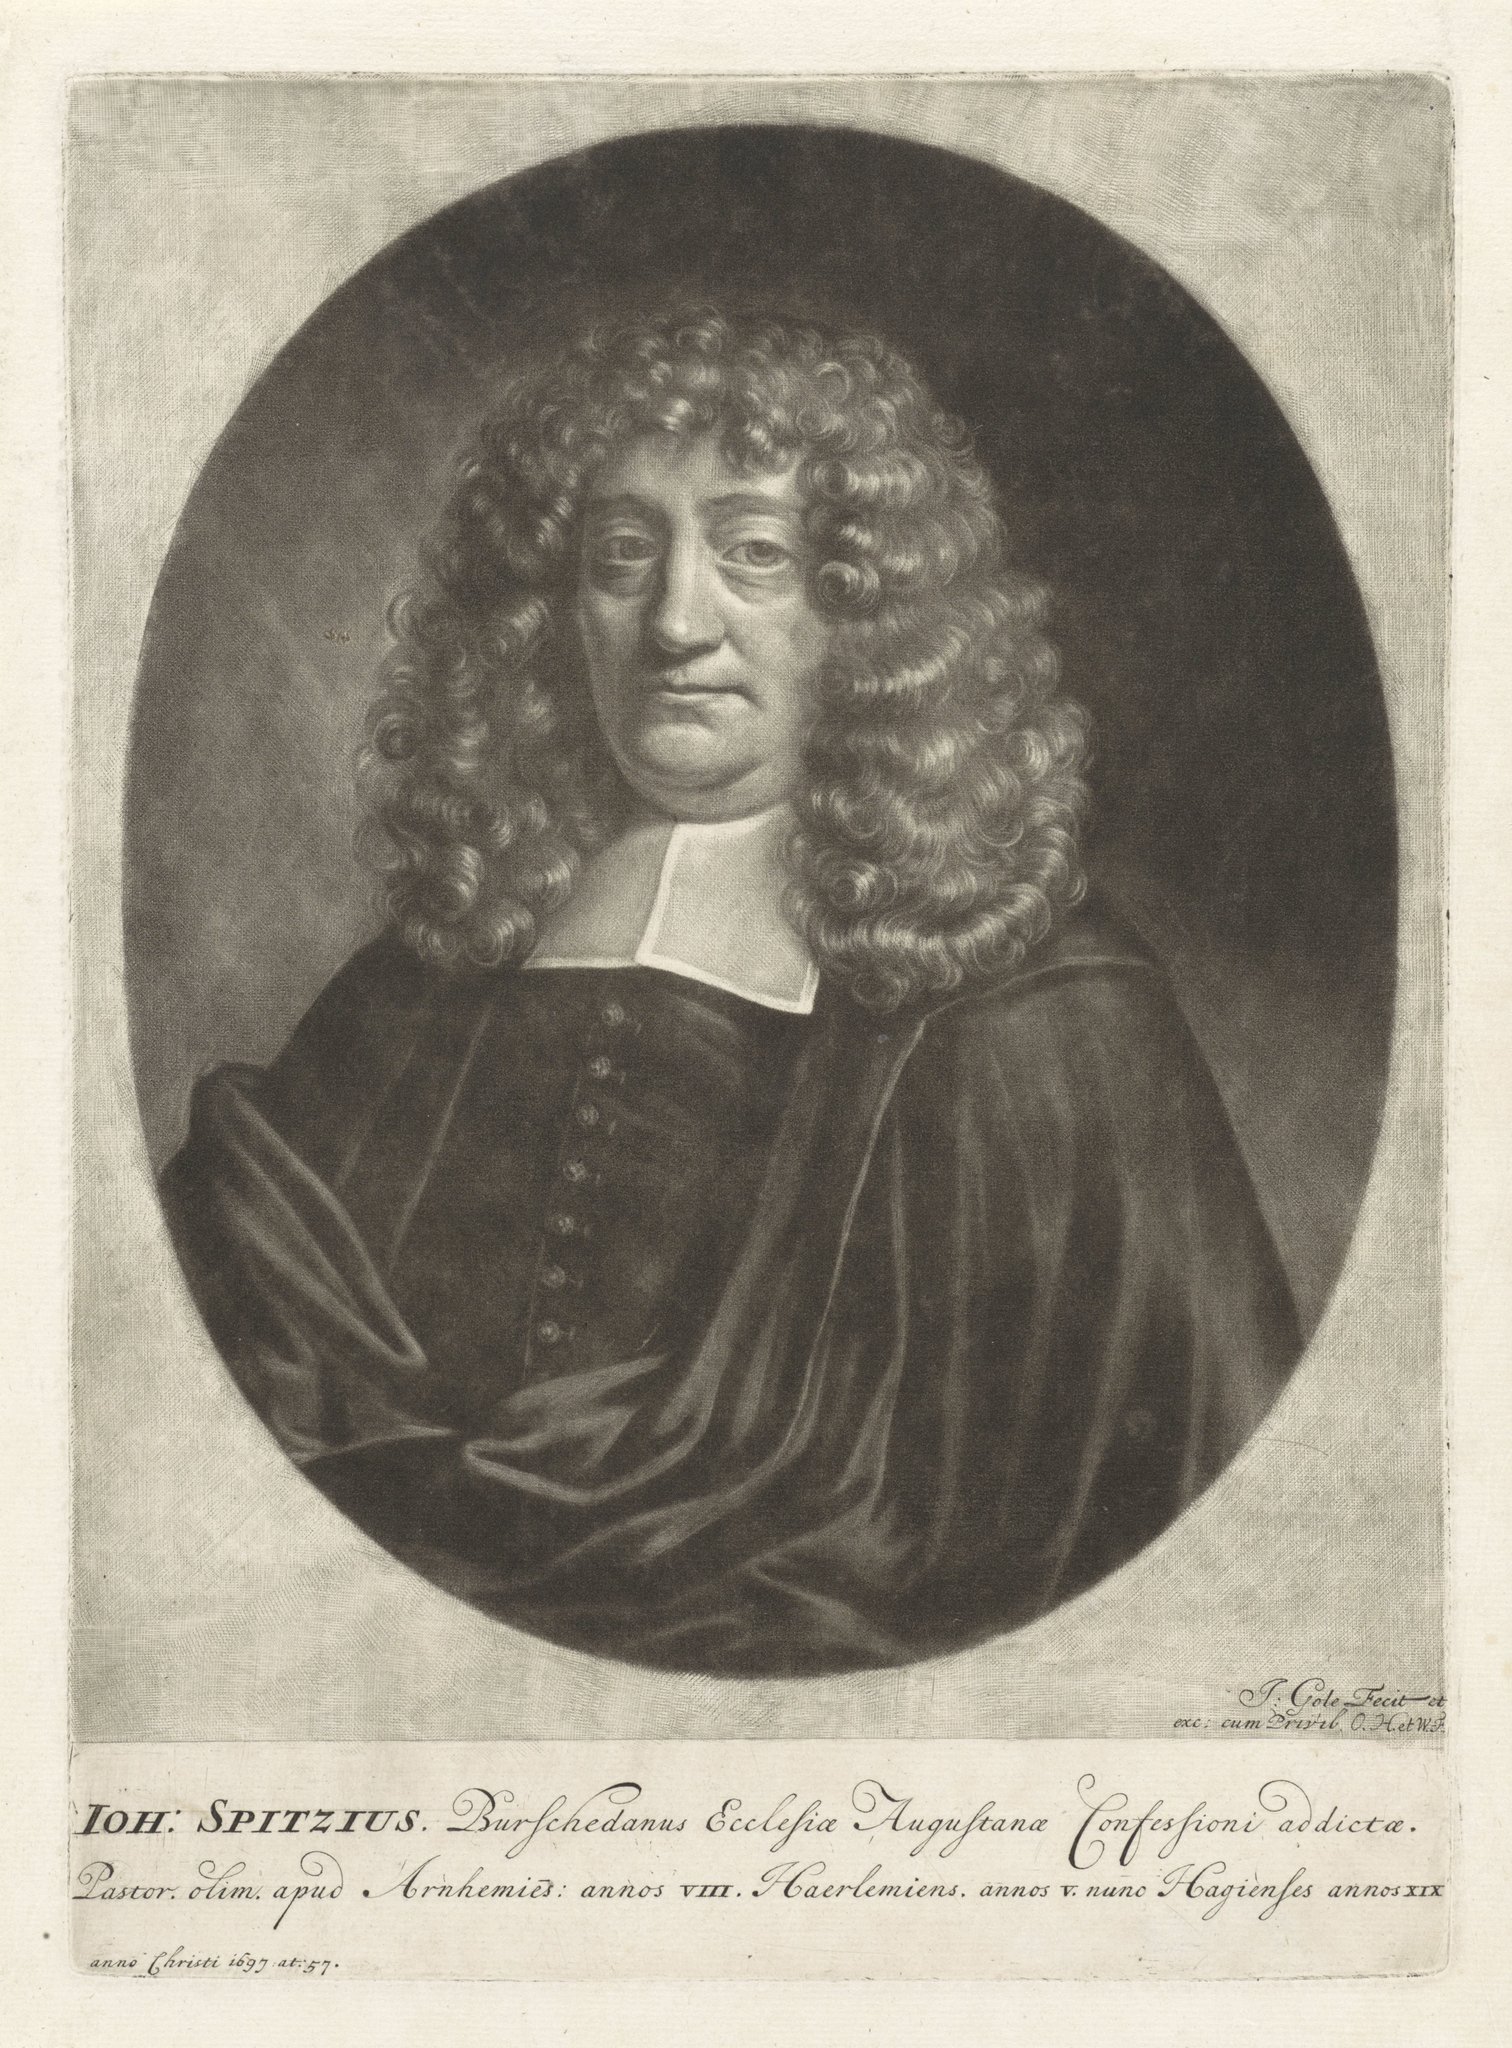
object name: print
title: Portret van Johan Spitzius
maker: jacob gole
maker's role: print maker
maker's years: 1660-1724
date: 1697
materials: paper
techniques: engraving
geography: amsterdam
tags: pastoor, johan spitzius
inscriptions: collector's mark: Lugt 240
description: Johan Spitzius op 57-jarige leeftijd. Hij was Luthers predikant in Arnhem, Haarlem en Den Haag. In de marge zijn naam, leeftijd en titels in het Latijn.